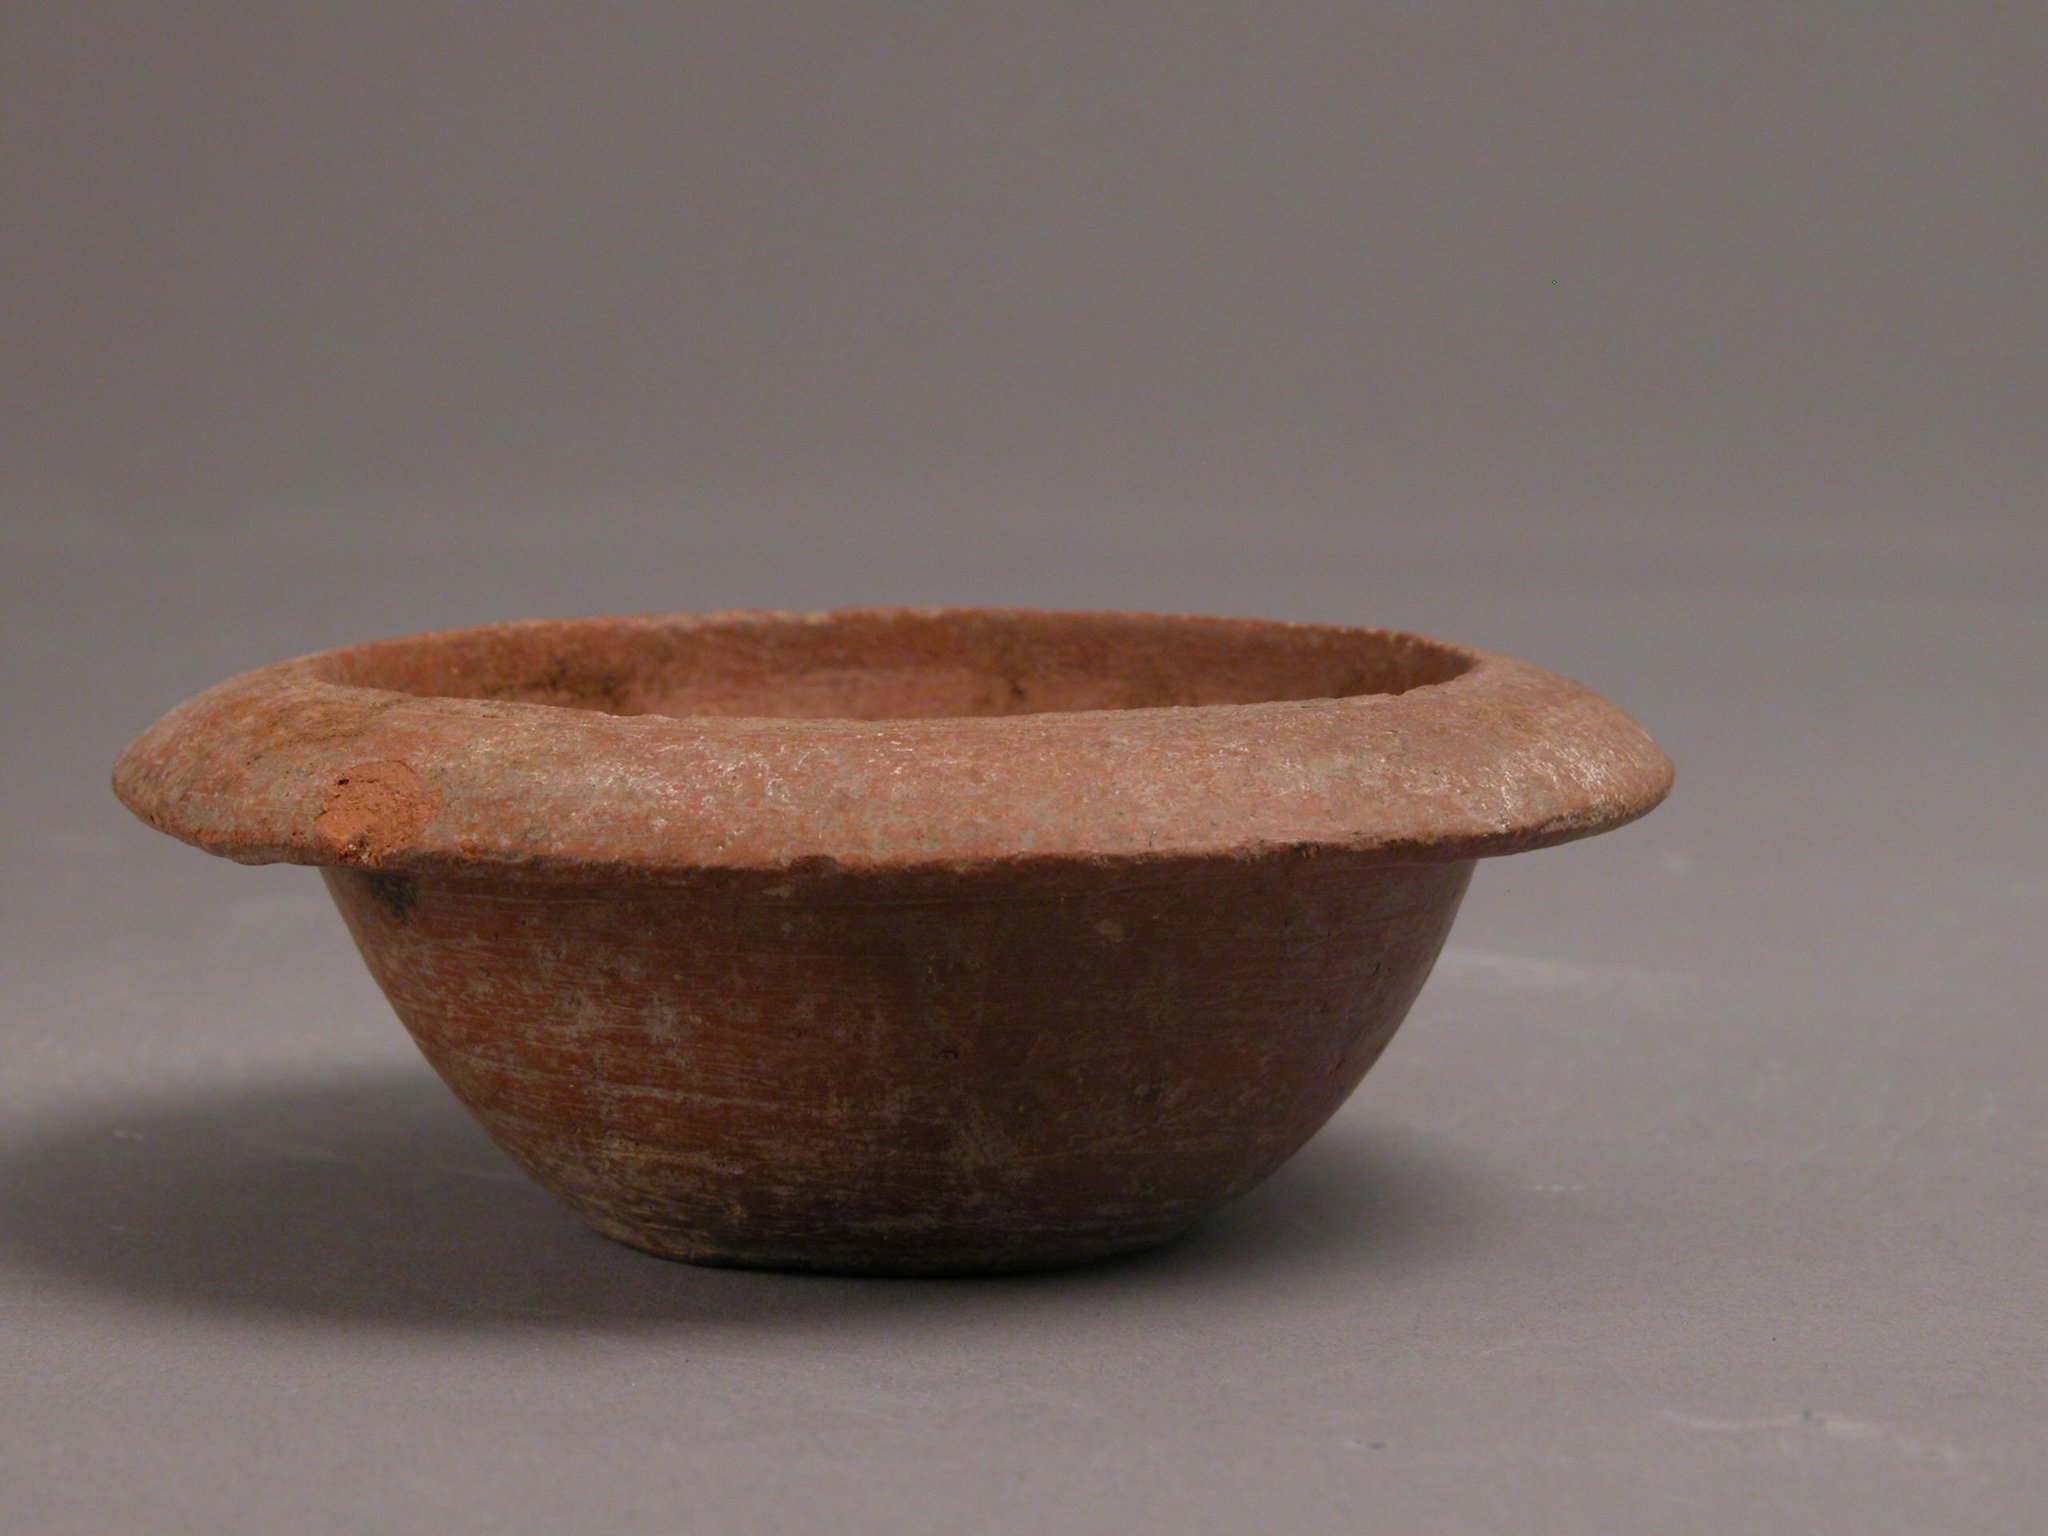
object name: bowl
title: Nesting Bowl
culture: coptic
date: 301-700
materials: earthenware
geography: egypt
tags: bowls